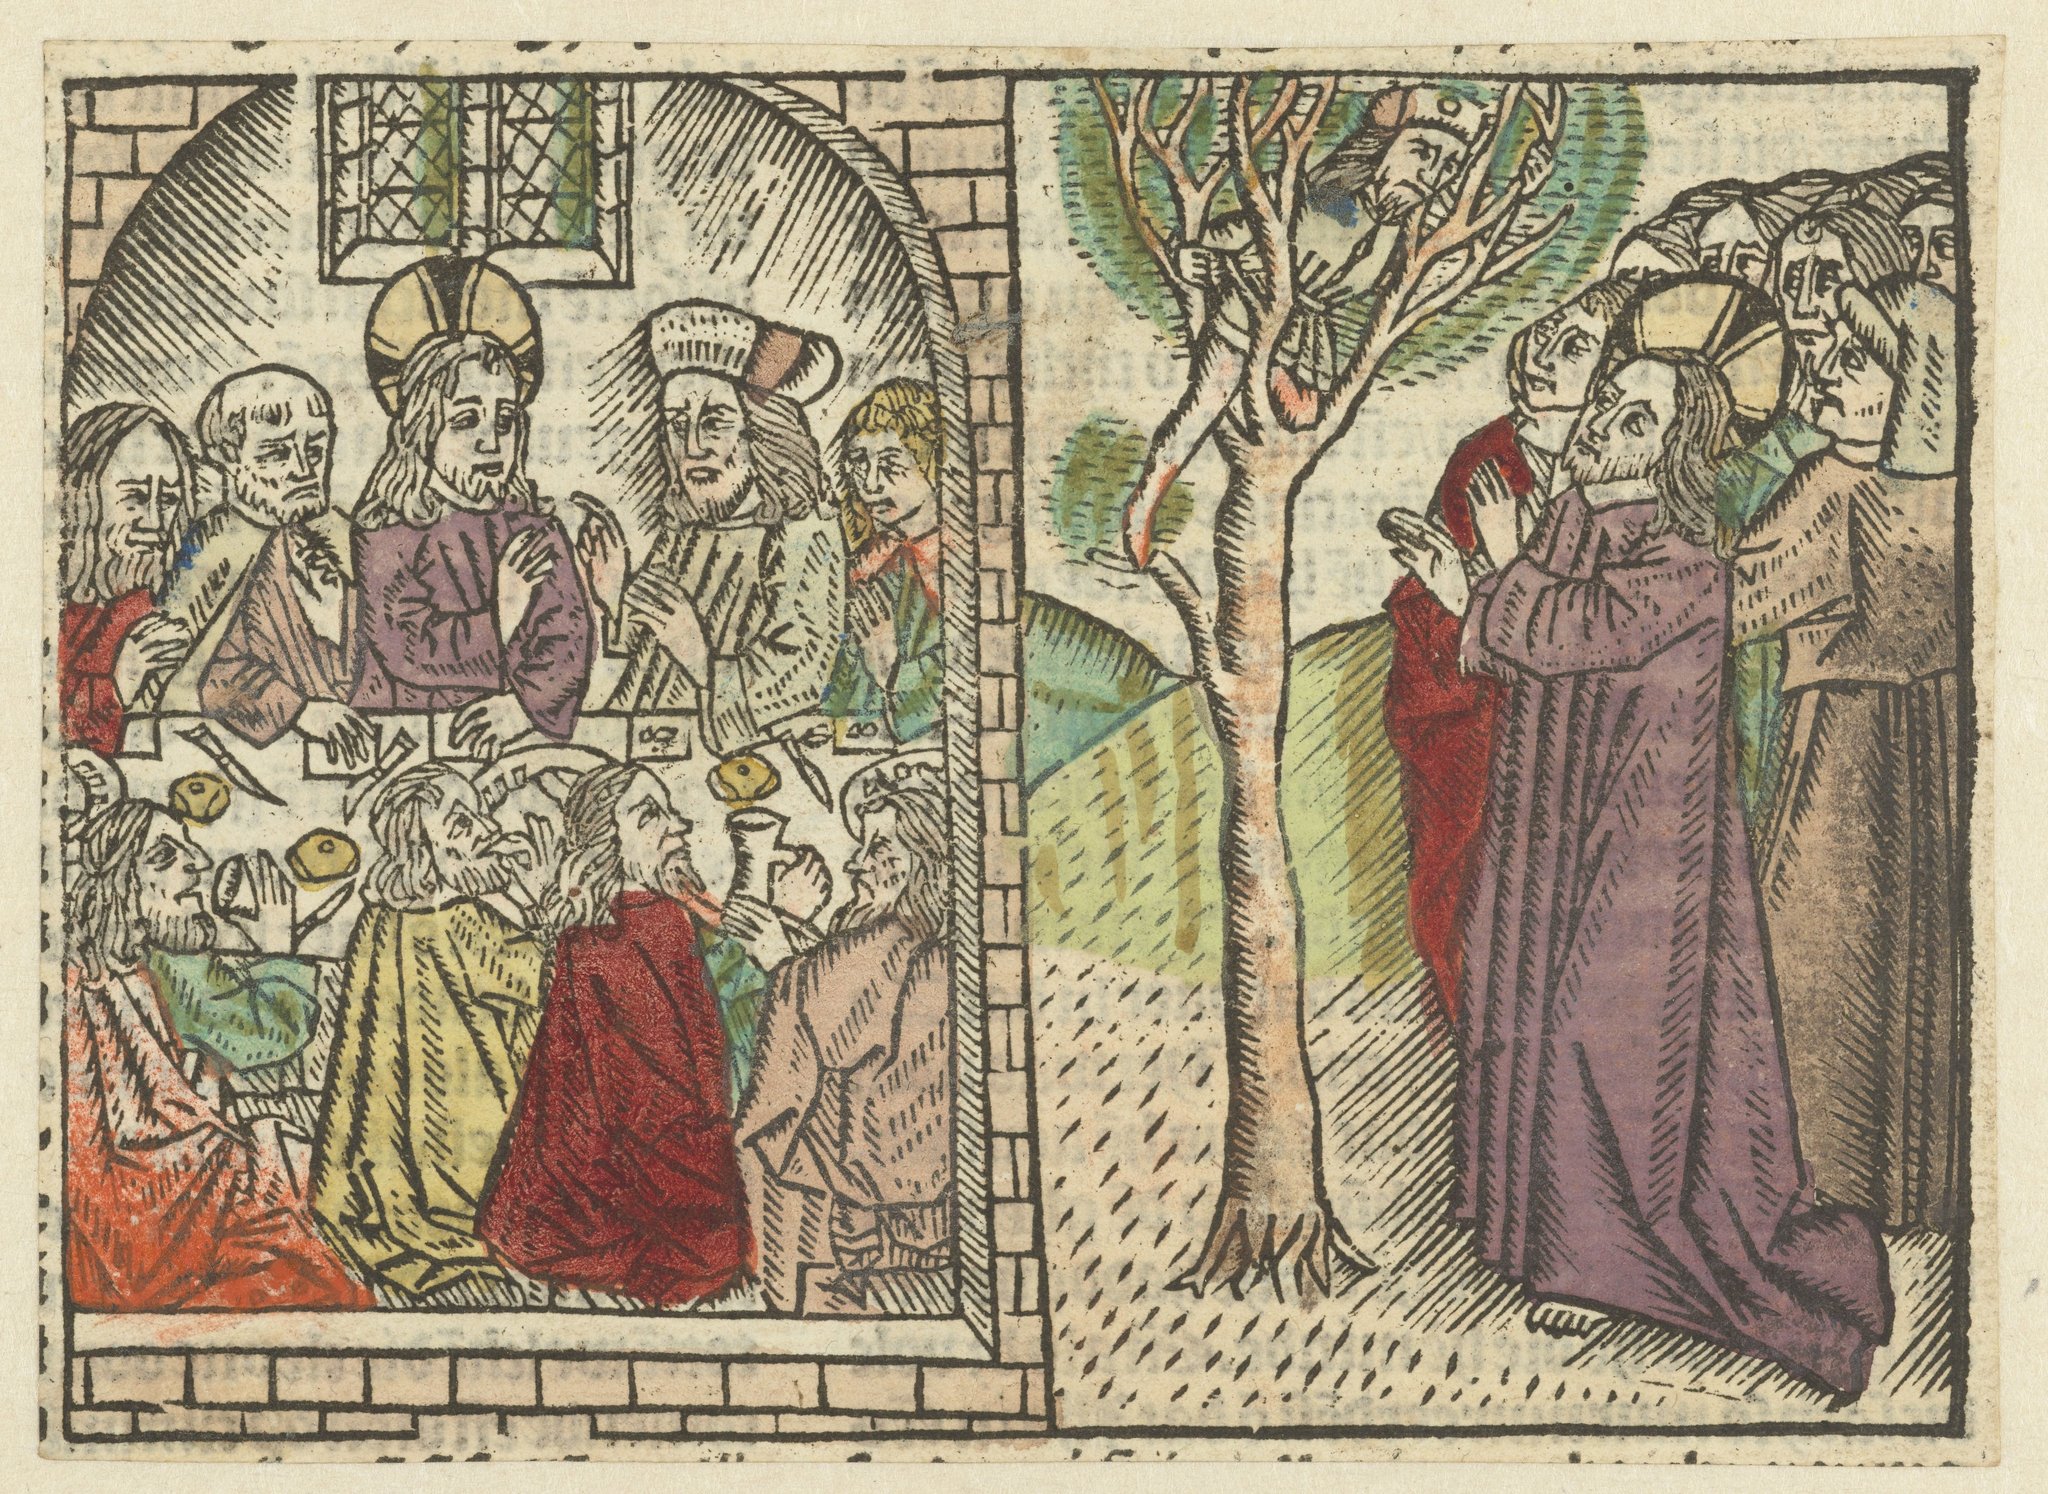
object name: book illustration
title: De maaltijd in het huis van Zacheus; Zacheus in de vijgeboom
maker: the first antwerp woodcutter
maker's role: print maker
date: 1485-1491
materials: paper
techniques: hand coloring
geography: low countries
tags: calling of zacchaeus, who is sitting in a fig-tree (christ passing through jericho), meal at the house of zacchaeus, the tax-collector (luke 19:1-10)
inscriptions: collector's mark: Lugt 2228a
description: Eén van 46 houtsnedes uit Ludolphus de Saxonia "Tboeck vandan leven ons heeren Jesu Christi", een anonieme Nederlandse vertaling. Deze versie van het werk van Ludolphus bevat houtsneden van de Meester van Gouda (II), de Meester van Antwerpen (I) en de Meester van Haarlem. Botke, K. Boek van Ludolphus is voor het eerst uitgegeven in 1487 door Geeraert Leeu te Antwerpen. In 1488 uitgegeven door Claes Leeu te Antwerpen, in 1495 en 1499 en 1519 door Peter van Os te Zwolle en in 1510 door A. van Berghen te Antwerpen. Deze 46 houtsneden komen waarschijnlijk uit een uitgave van Peter van Os. Botke, K.